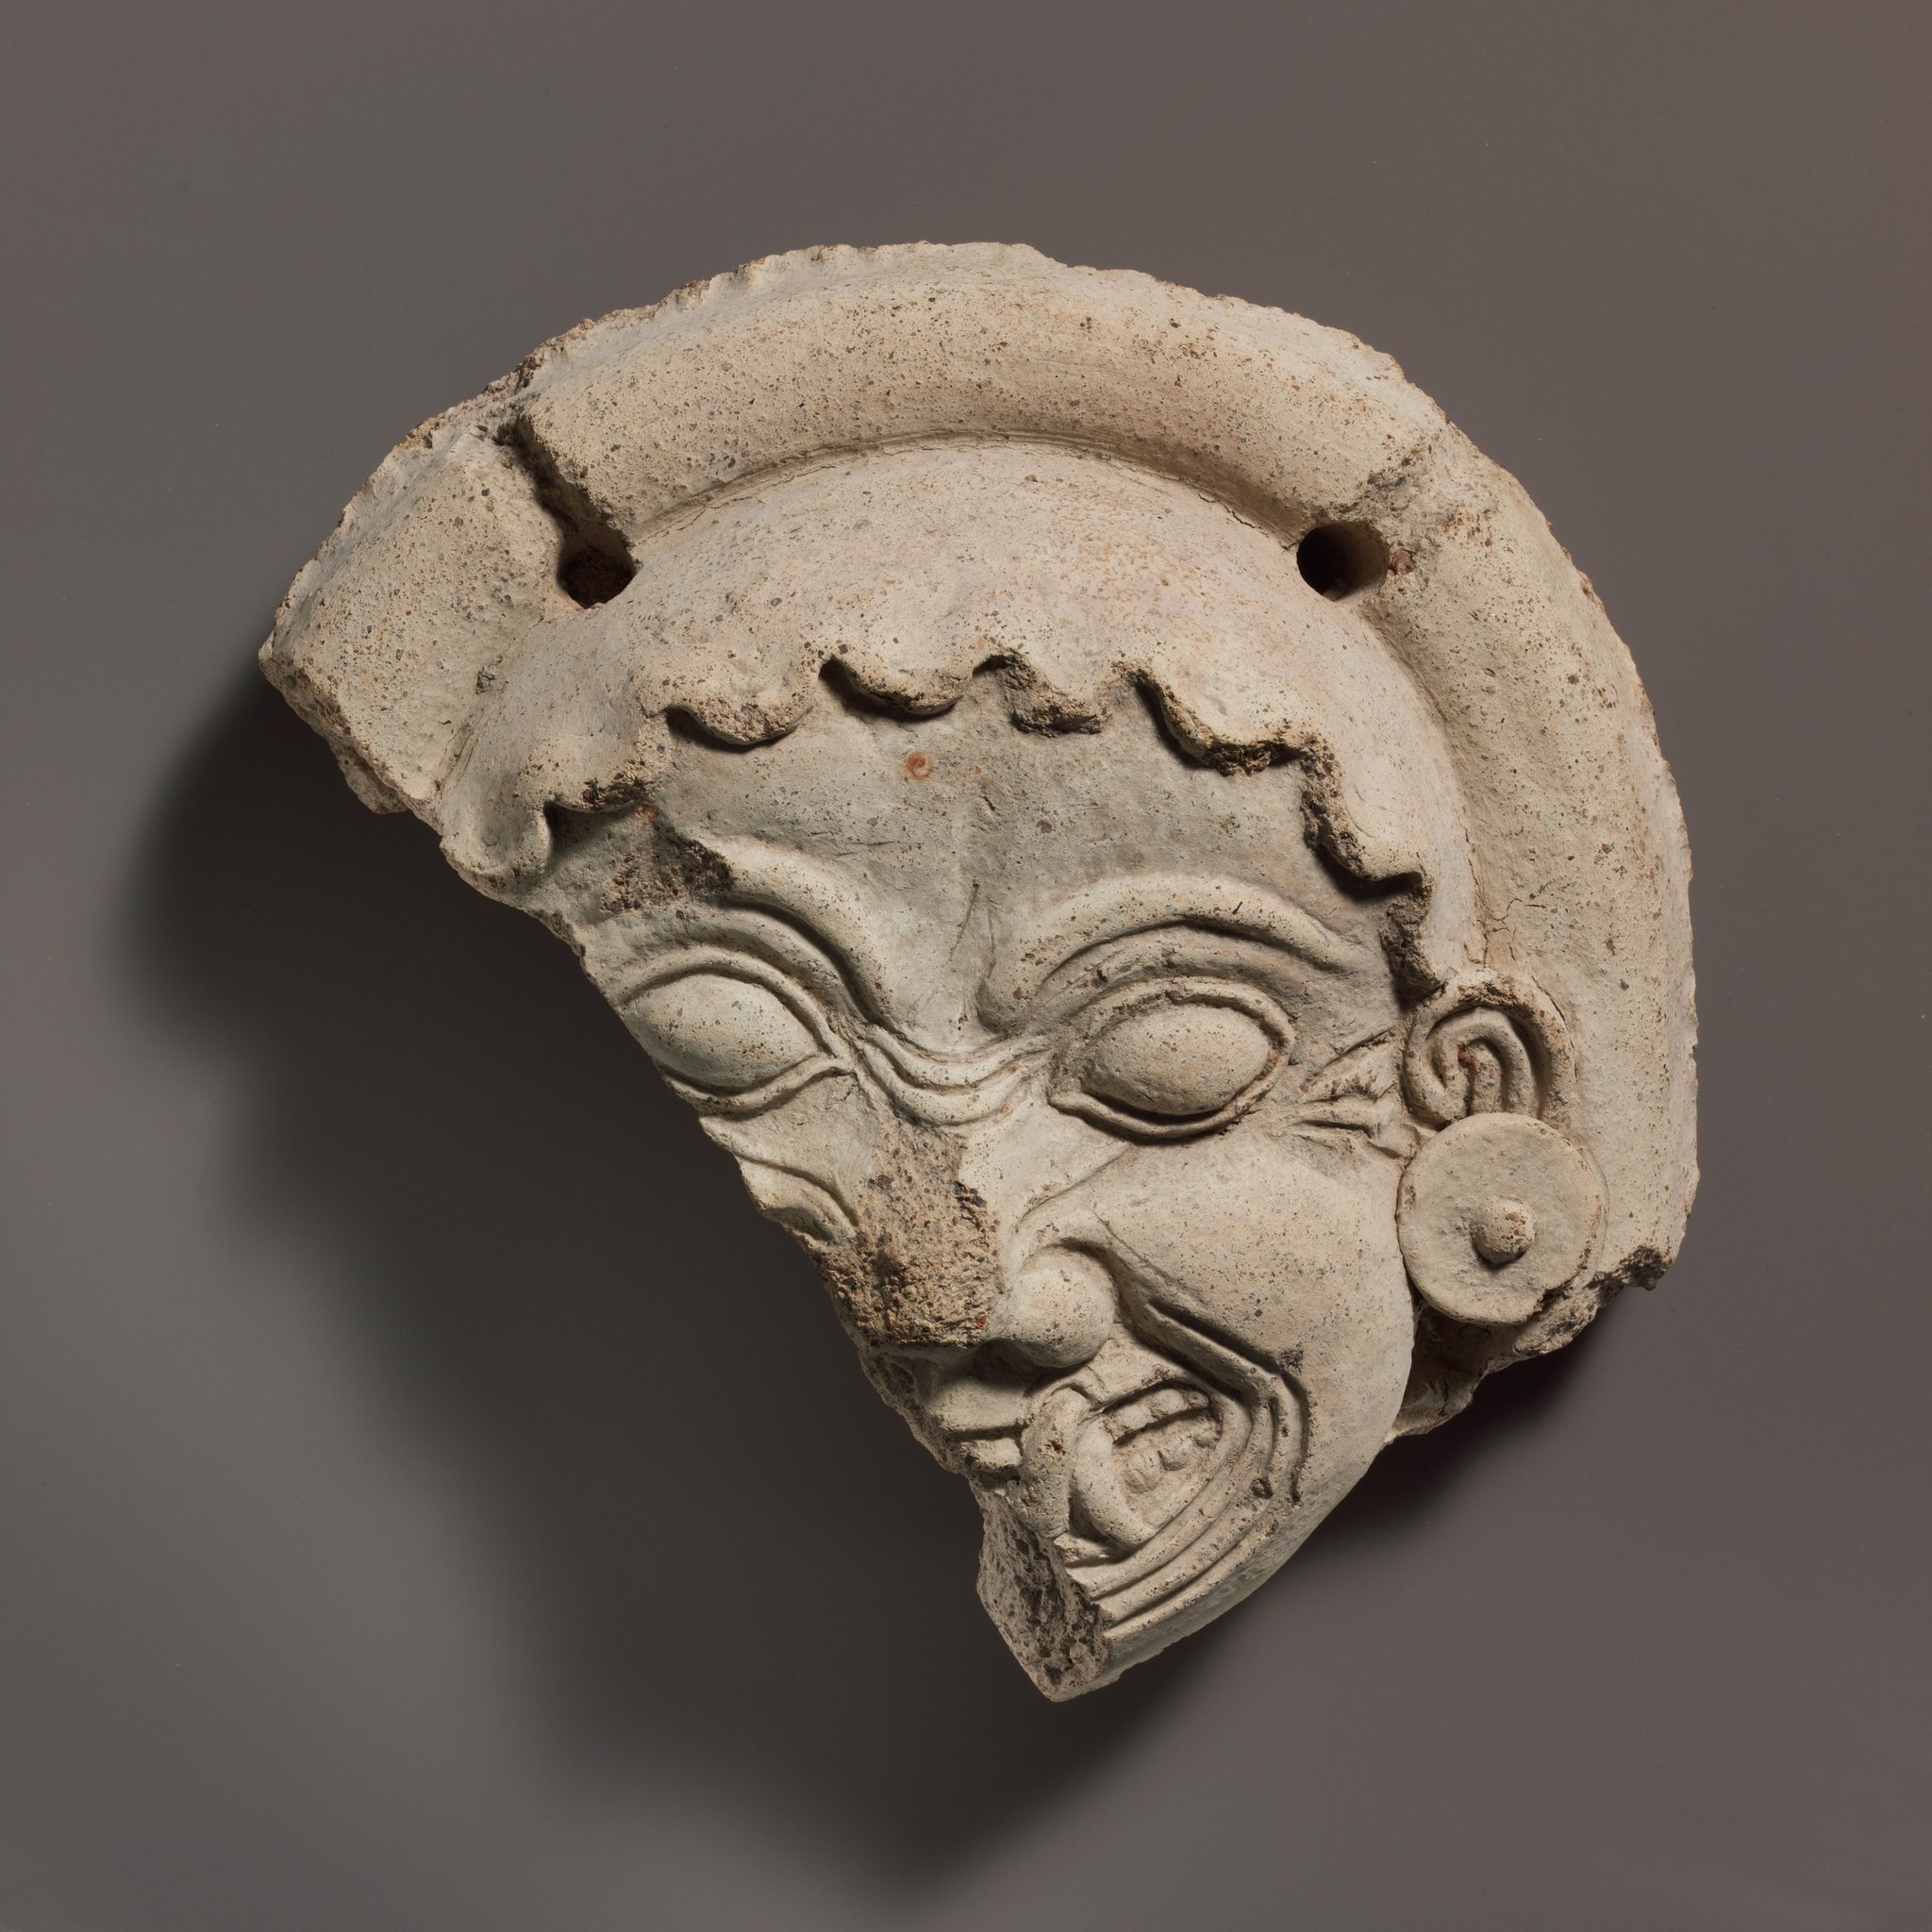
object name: antefix, gorgoneion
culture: etruscan or italian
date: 600-401 BCE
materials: terracotta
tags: gorgons